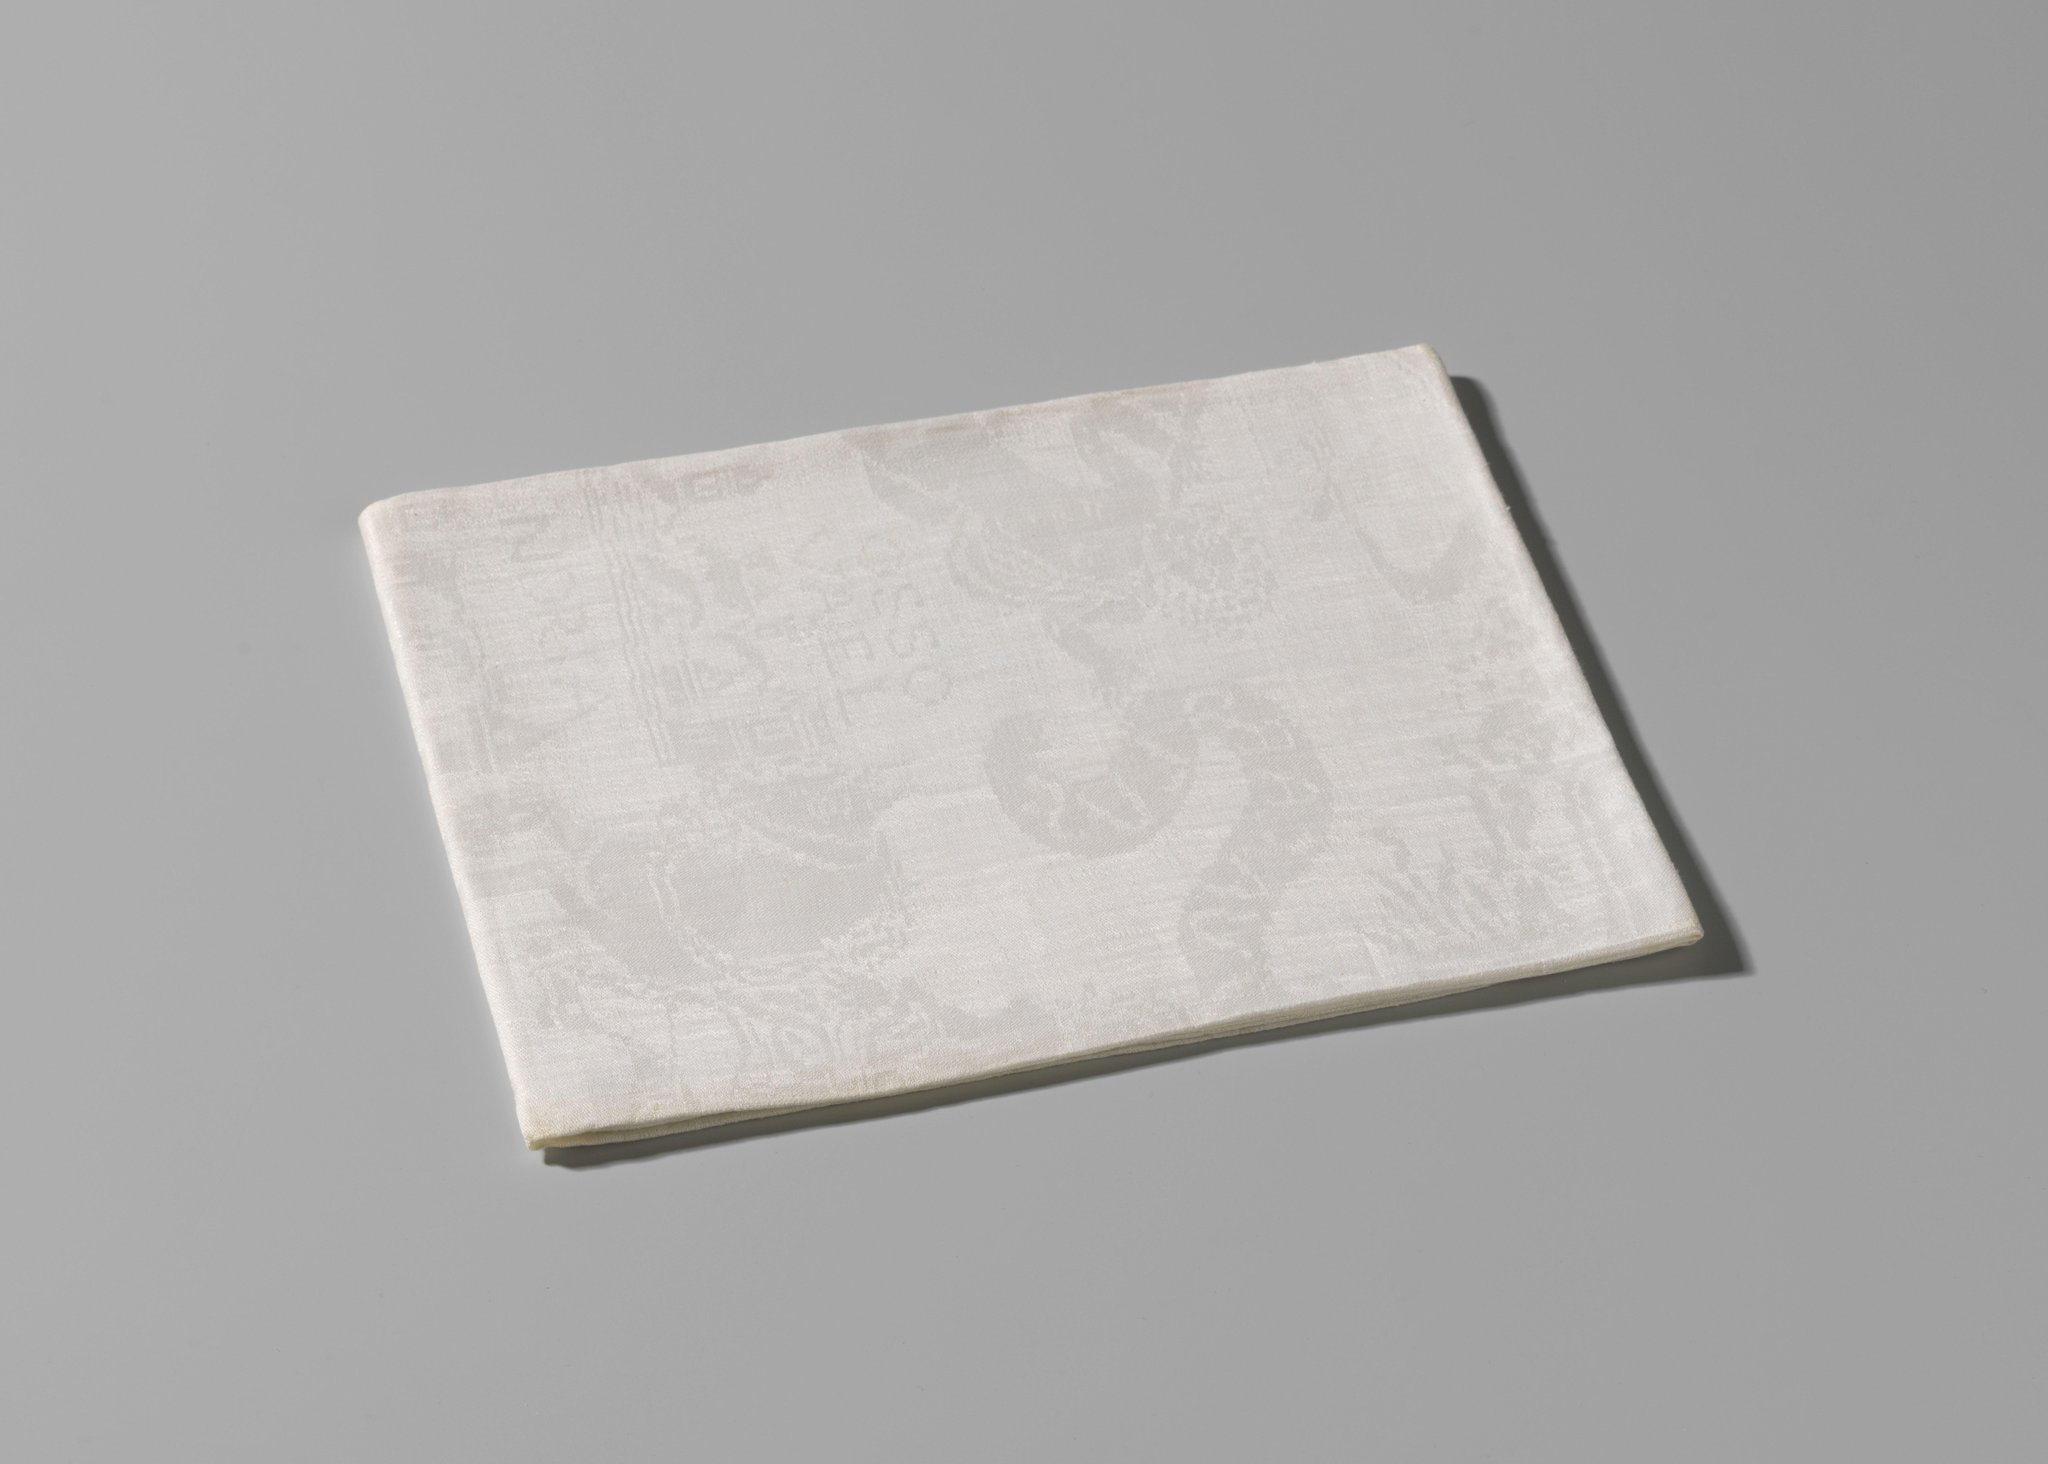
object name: napkin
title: Servet van wit linnendamast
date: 1717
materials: linen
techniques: damask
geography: flanders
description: Wit linnen damasten servet met de overwinningen op de Turken door Eugenius van Savoye onder Karel VI van Oostenrijk. Gemerkt T C 38.